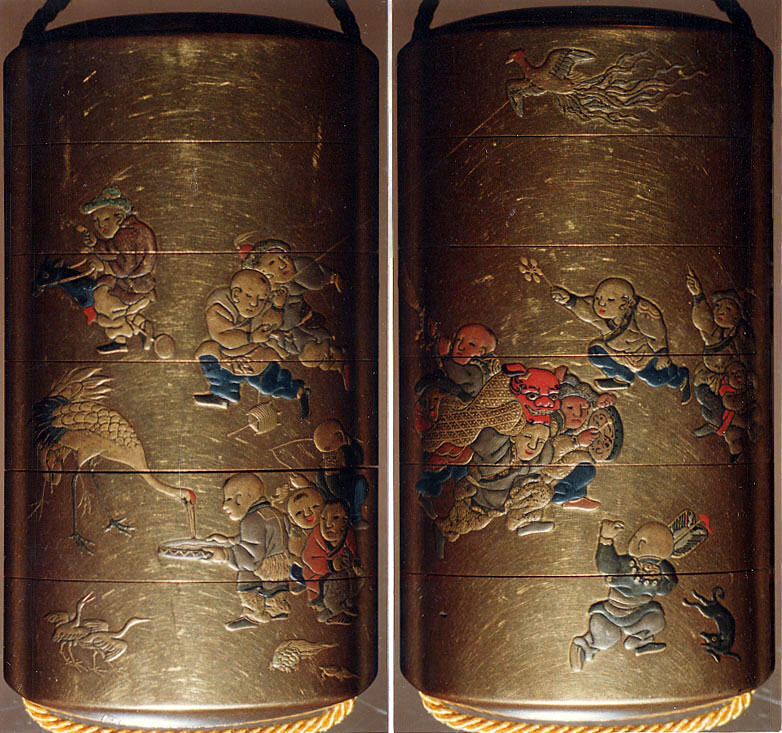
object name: inrō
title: Case (Inrō) with Design of Chinese Children at Play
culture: japanese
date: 1801-1900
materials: gold, lacquer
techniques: fundame, hiramakie, maki-e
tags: animals,birds,boys,playing